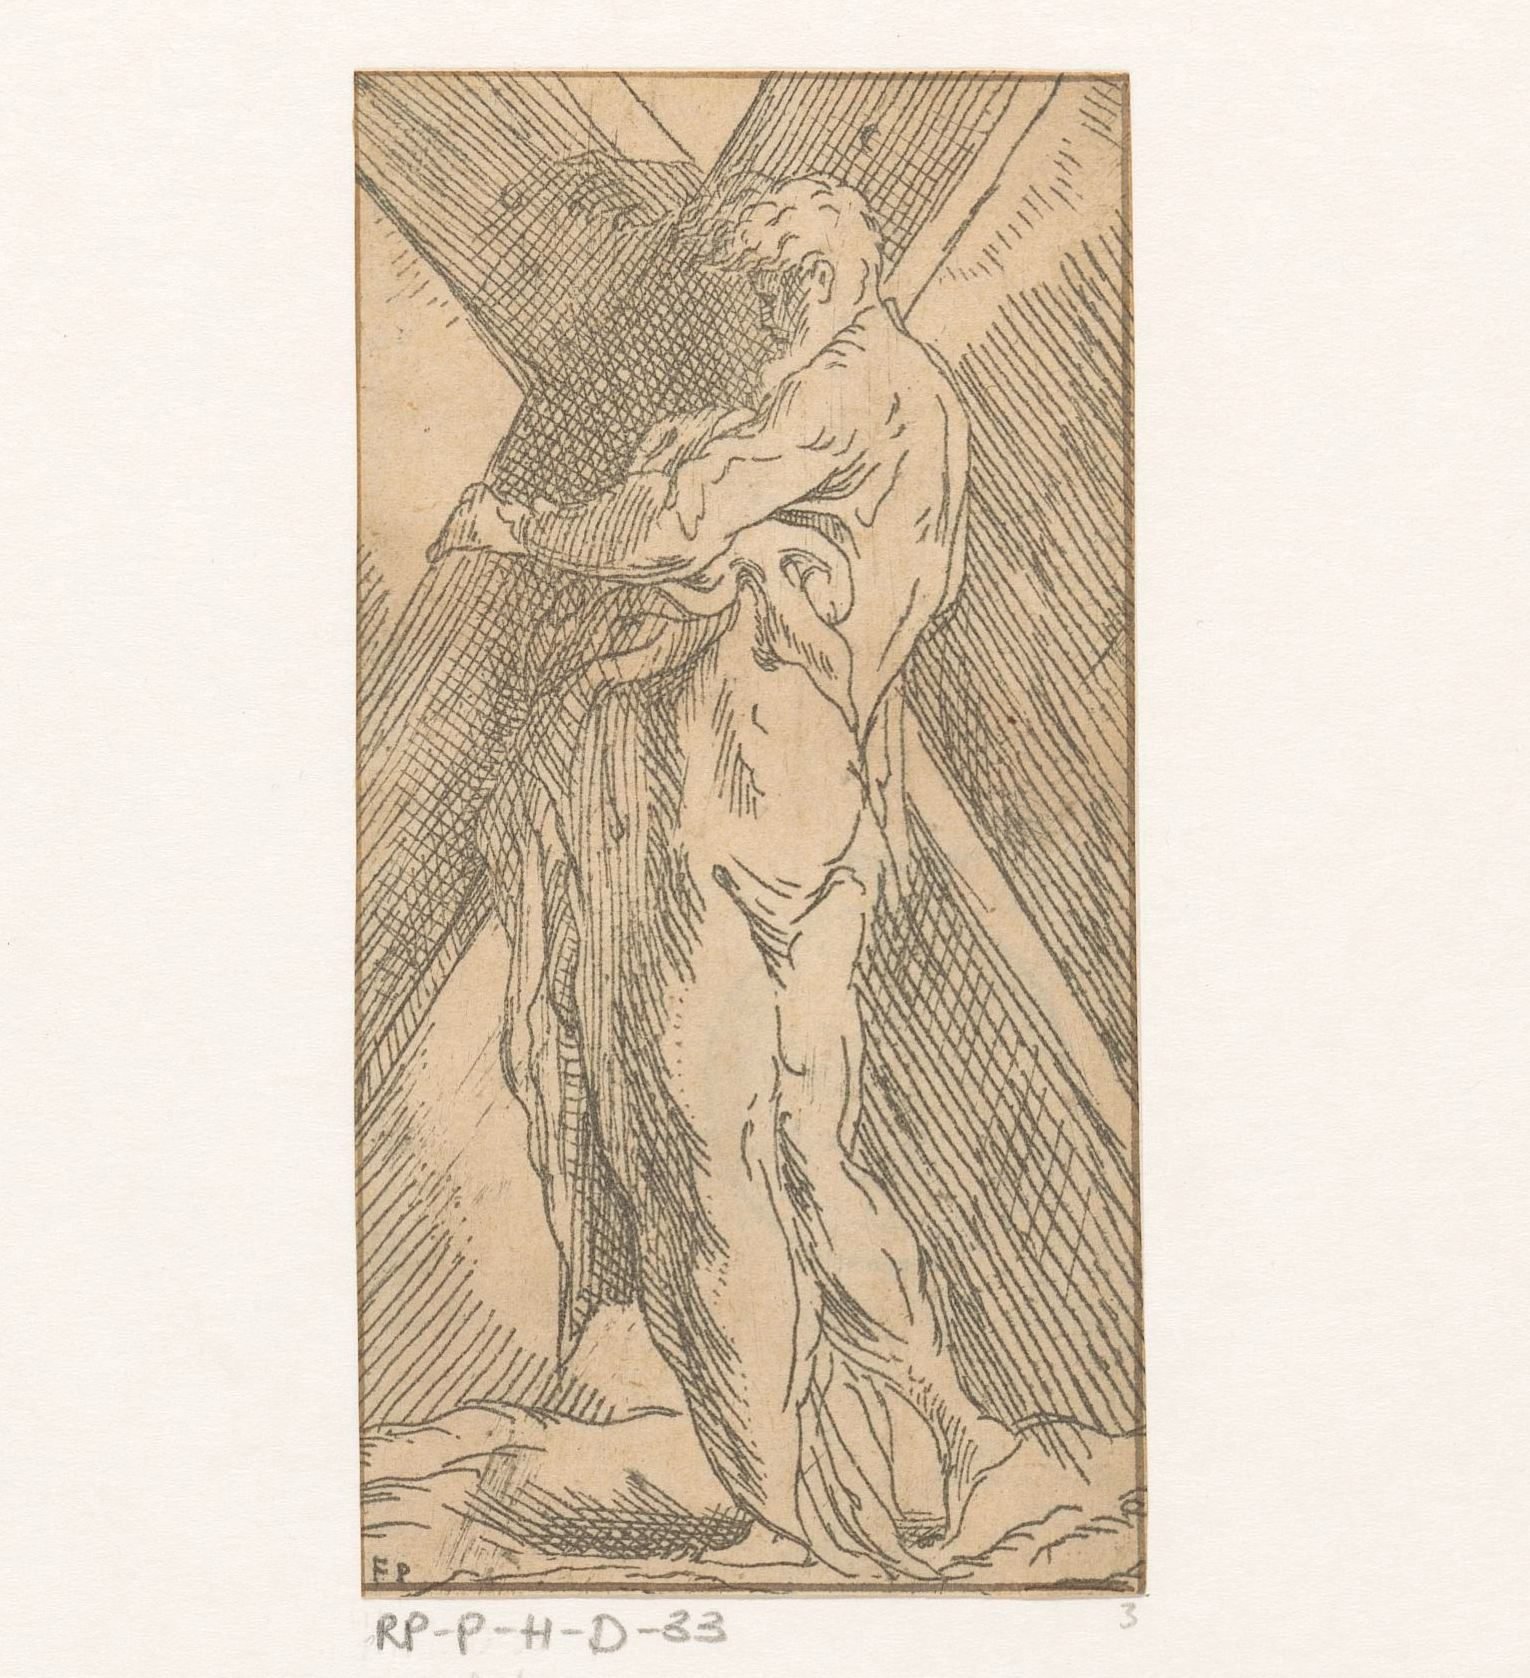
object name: print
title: Christus en de apostelen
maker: monogrammist fp (italië; 16e eeuw)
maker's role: print maker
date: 1500-1599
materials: paper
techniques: etching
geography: italy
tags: the apostle andrew; possible attributes: book, x-shaped cross, fish, fishing-net, rope, scroll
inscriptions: collector's mark: ‘Hinloopen’, collector's mark: Lugt 10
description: Deze prent maakt deel uit van een reeks van dertien prenten van Christus en de twaalf apostelen.